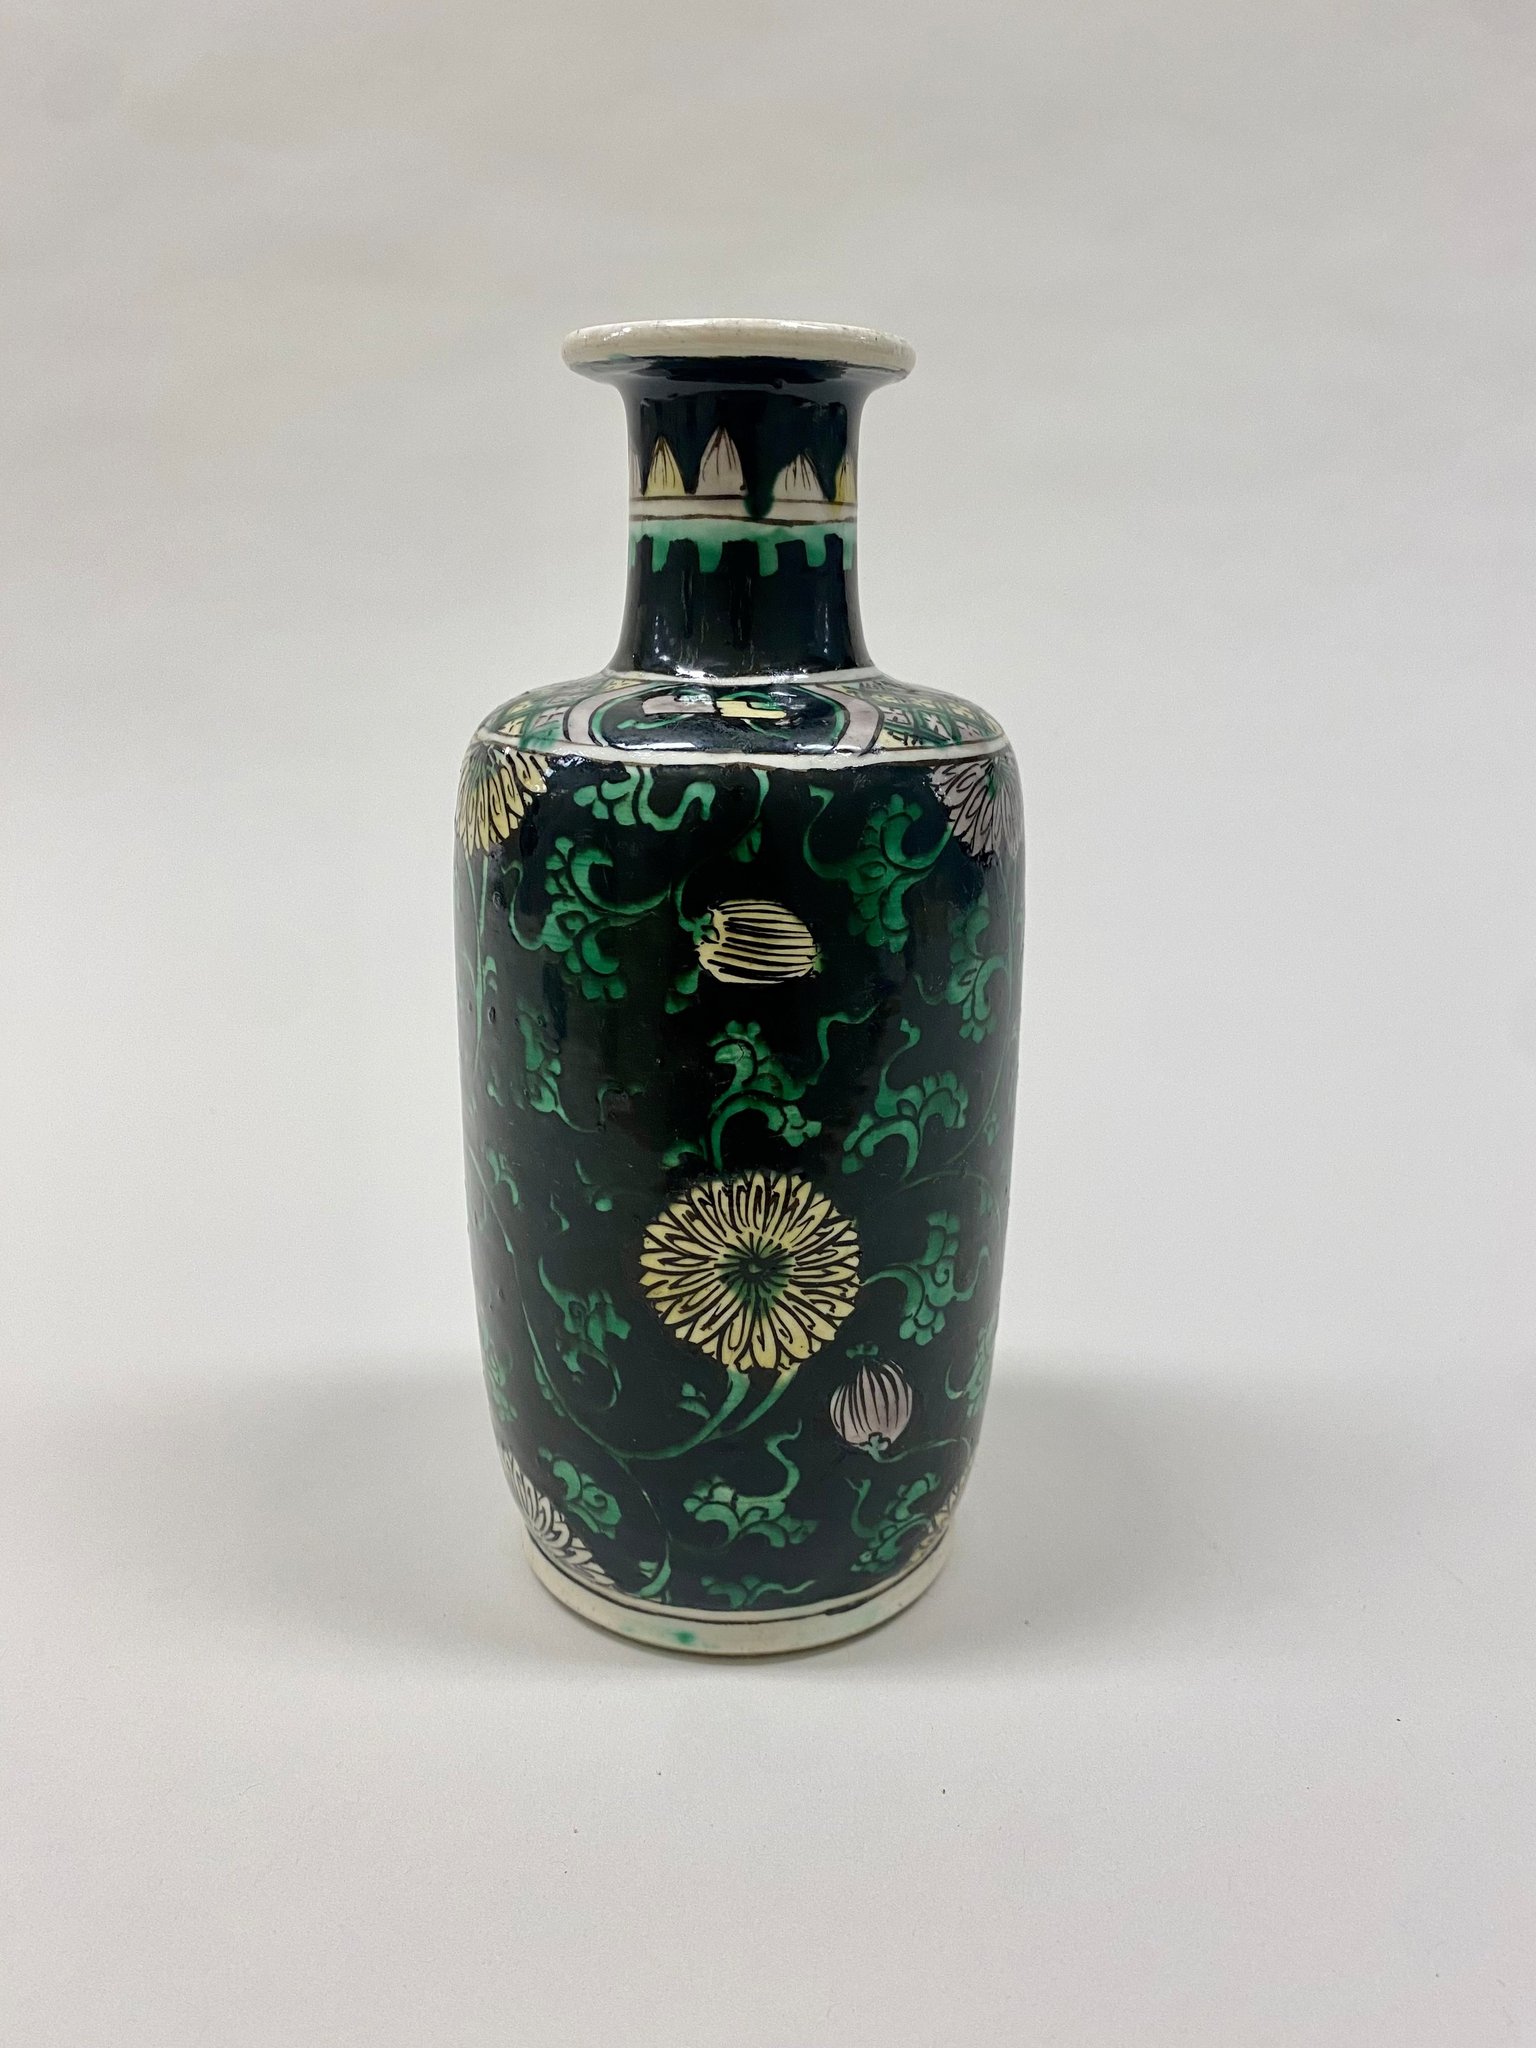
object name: vase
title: Vase with floral patterns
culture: chinese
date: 1801-1900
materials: enamel, porcelain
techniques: painting, polychrome